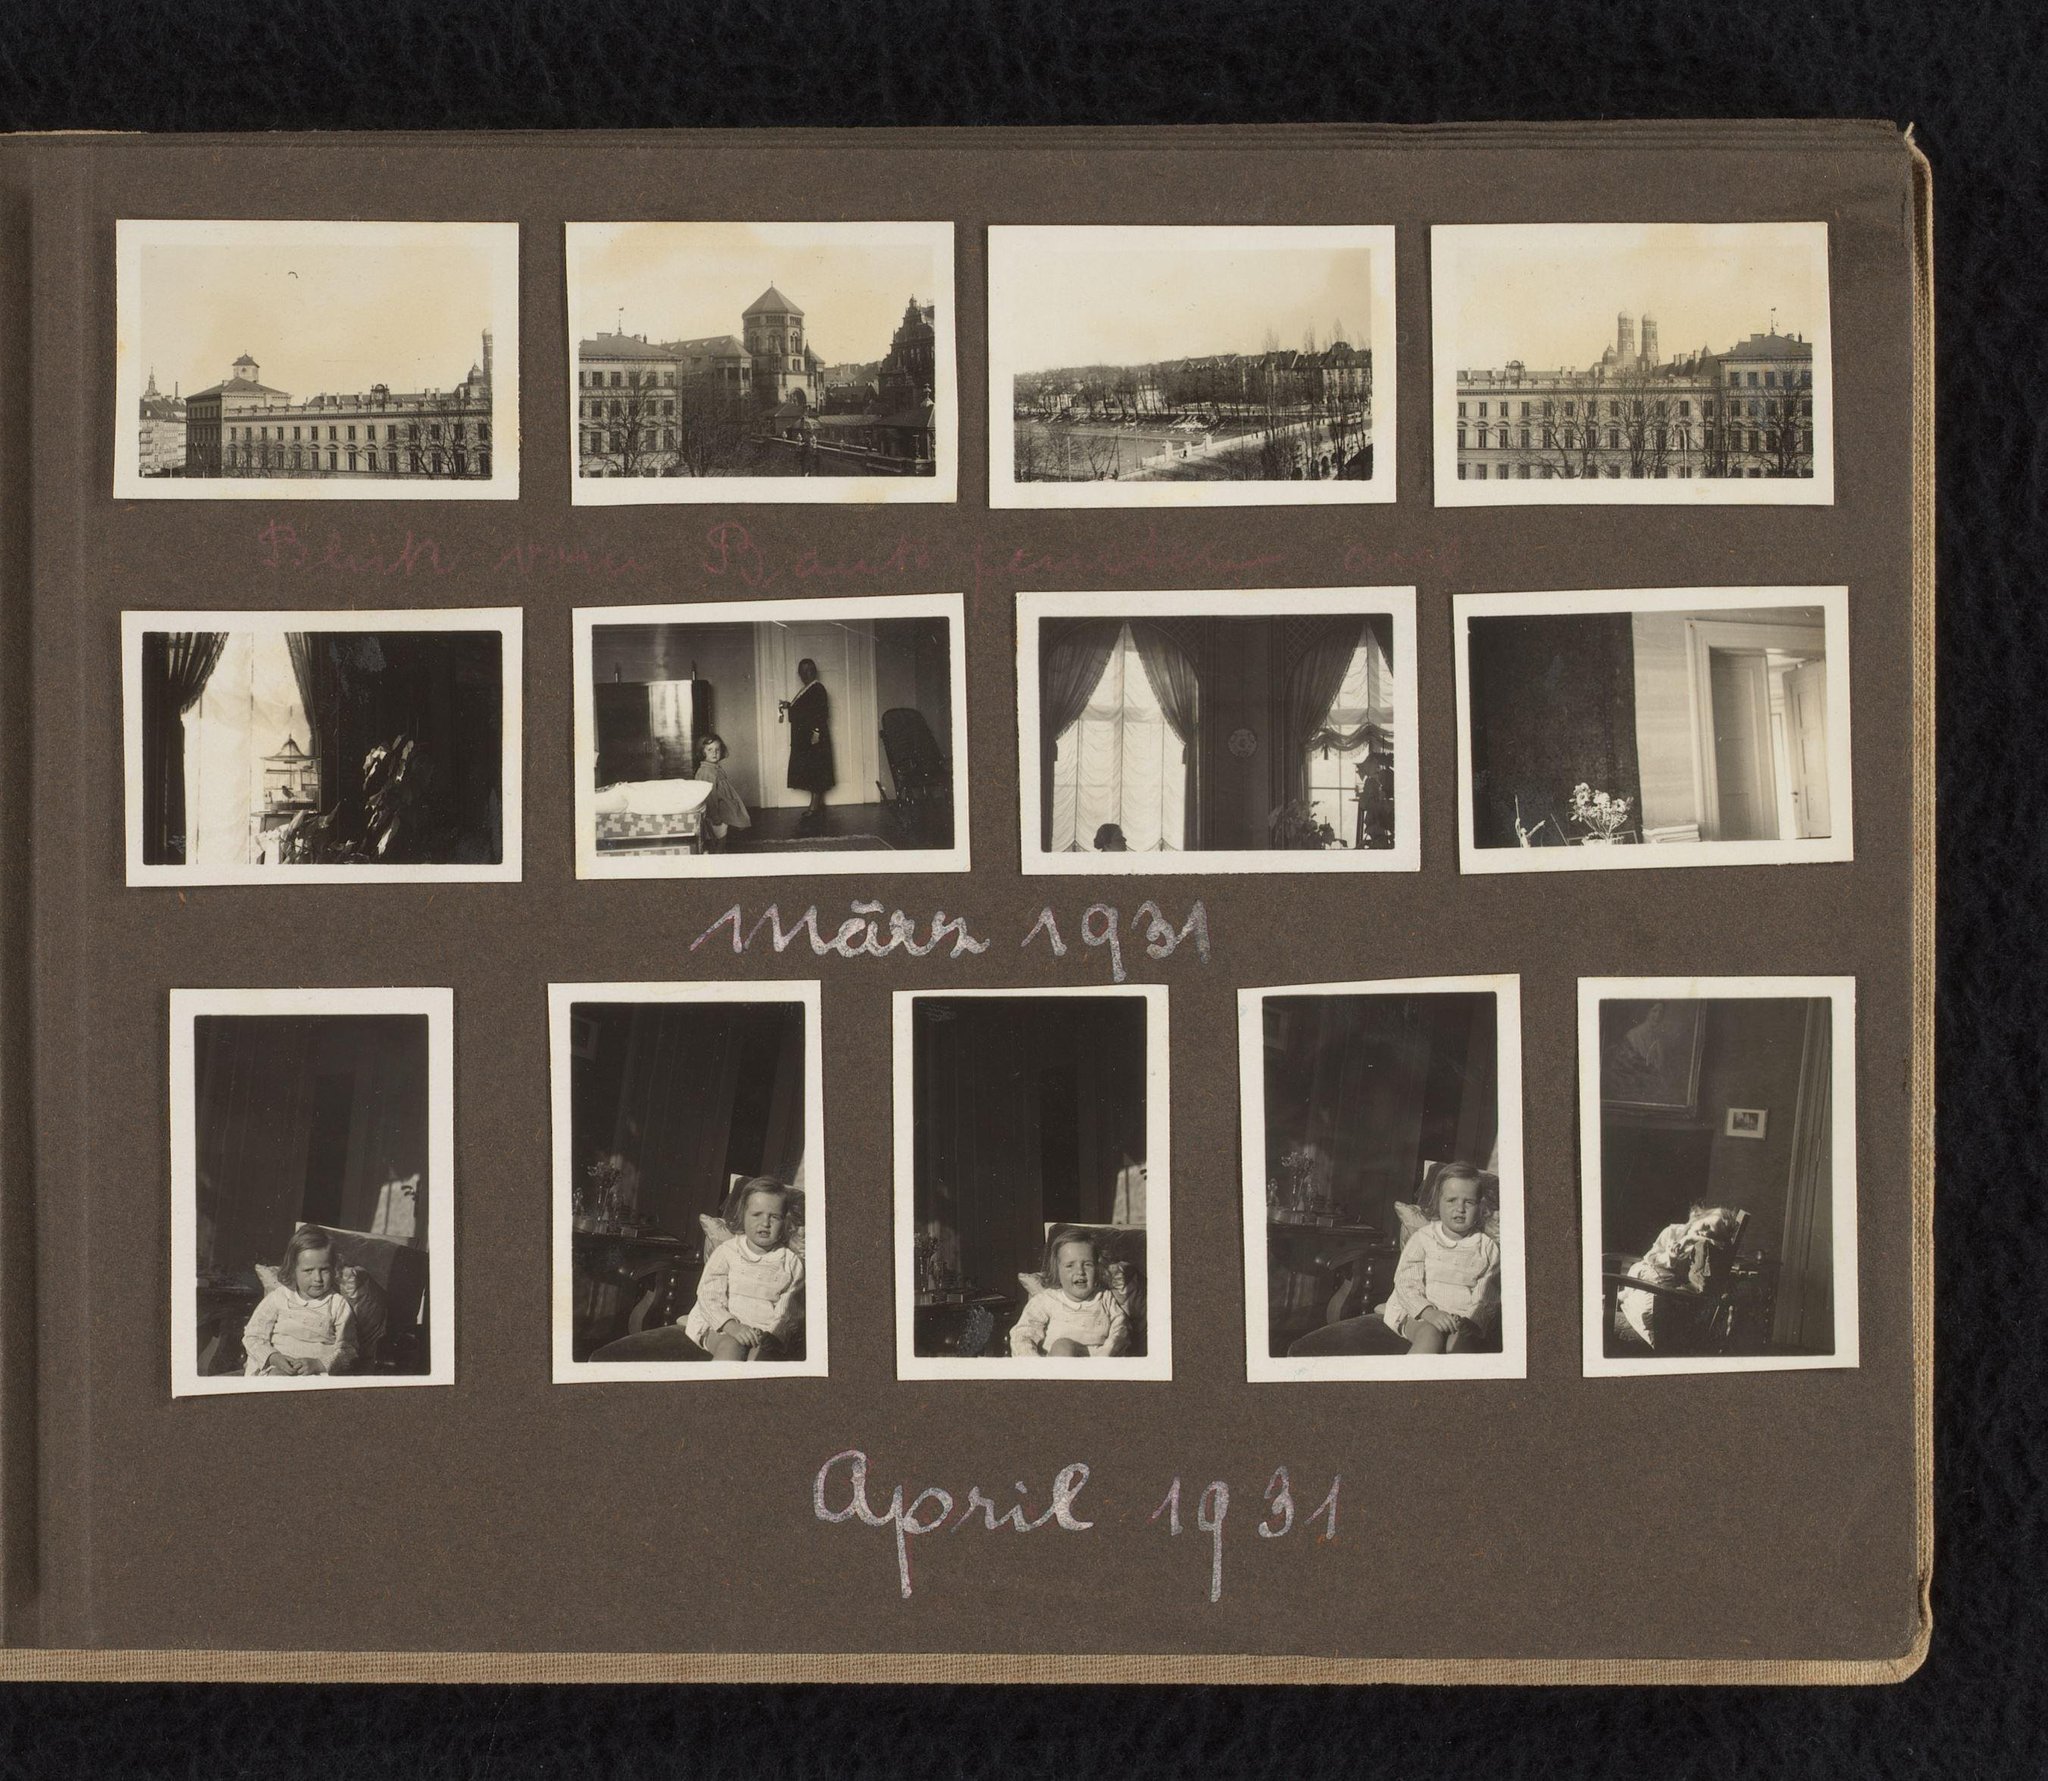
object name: album leaf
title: Buurt waar de familie Wachenheimer woonde, vanuit de woning van de familie, en Isabel met haar moeder Else Wachenheimer in de woning, maart-april 1931, München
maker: else wachenheimer-moos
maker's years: 1895-1944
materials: cardboard, photographic support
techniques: gelatin silver print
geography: munich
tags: else wachenheimer-moos, leiden, isabel wachenheimer-elon, family life at home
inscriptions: date: ‘März 1931 April 1931’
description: Blad bevat dertien foto's. Alle foto's van Isabel Wachenheimer (als jong meisje) en Else Wachenheimer-Moos (in donkere kleding), deel van afbeeldingen bevat enkel gebouwen. Uit het album, half formaat, crèmekleurig stofomslag met koordbinding met banenmotief.